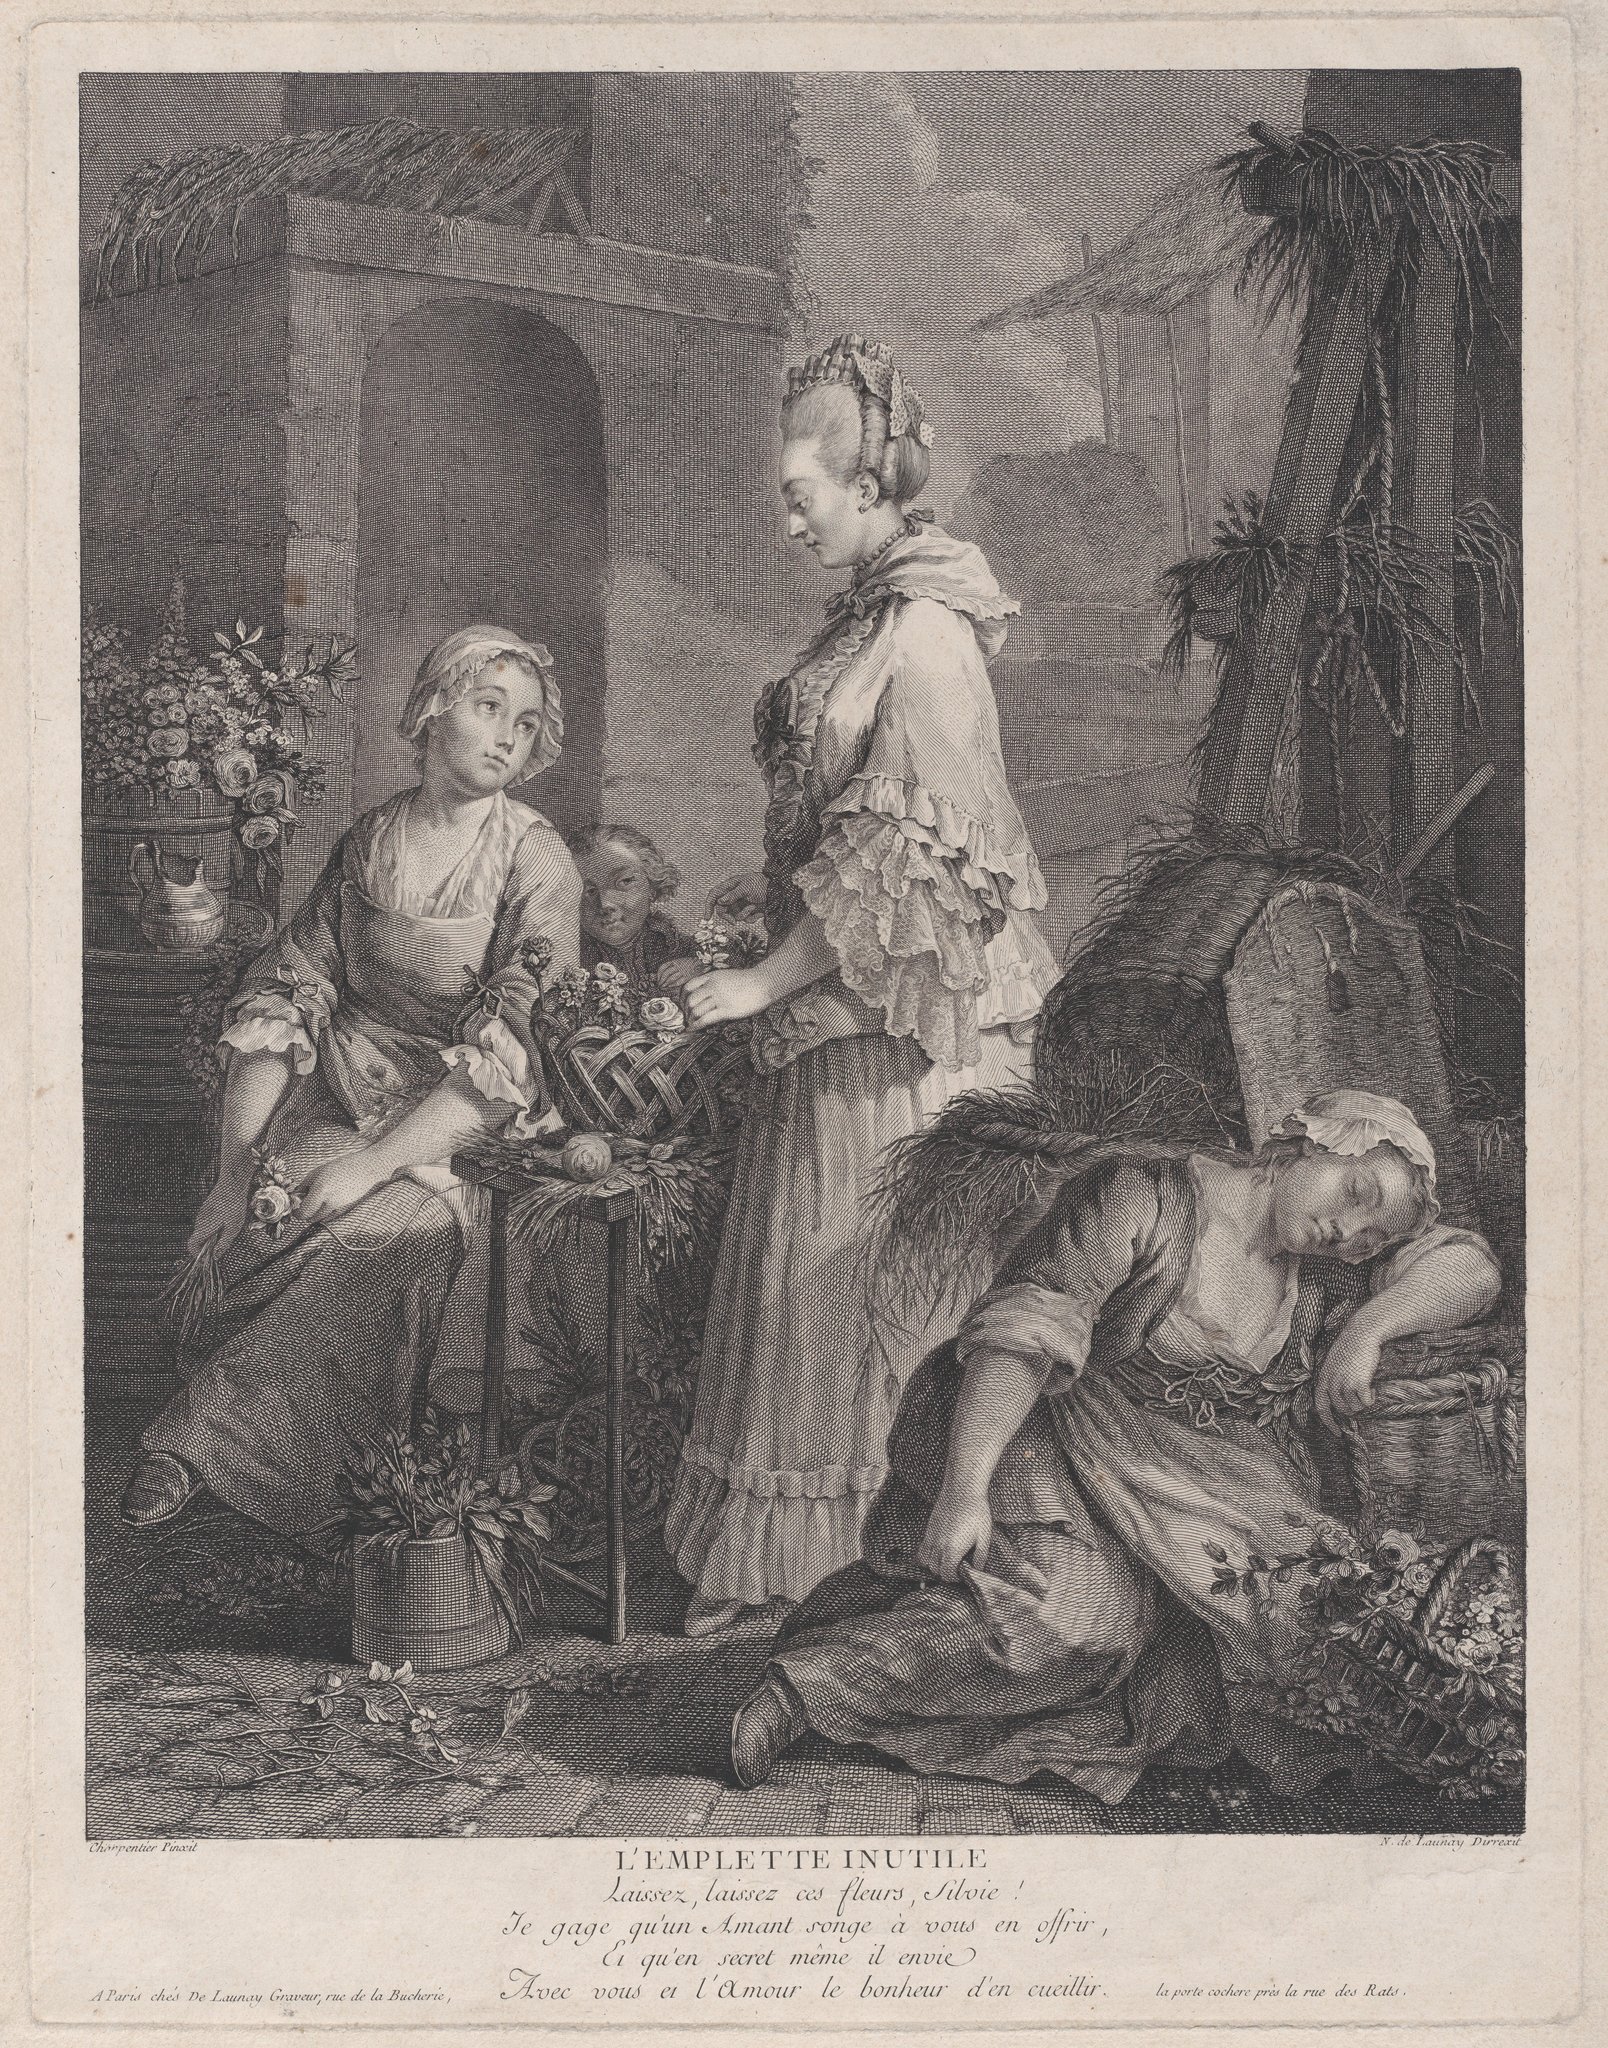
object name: print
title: L'Emplette Inutile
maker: nicolas de launay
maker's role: artist and publisher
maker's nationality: french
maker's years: 1739-1792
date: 1760-1792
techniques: engraving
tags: sleeping,women